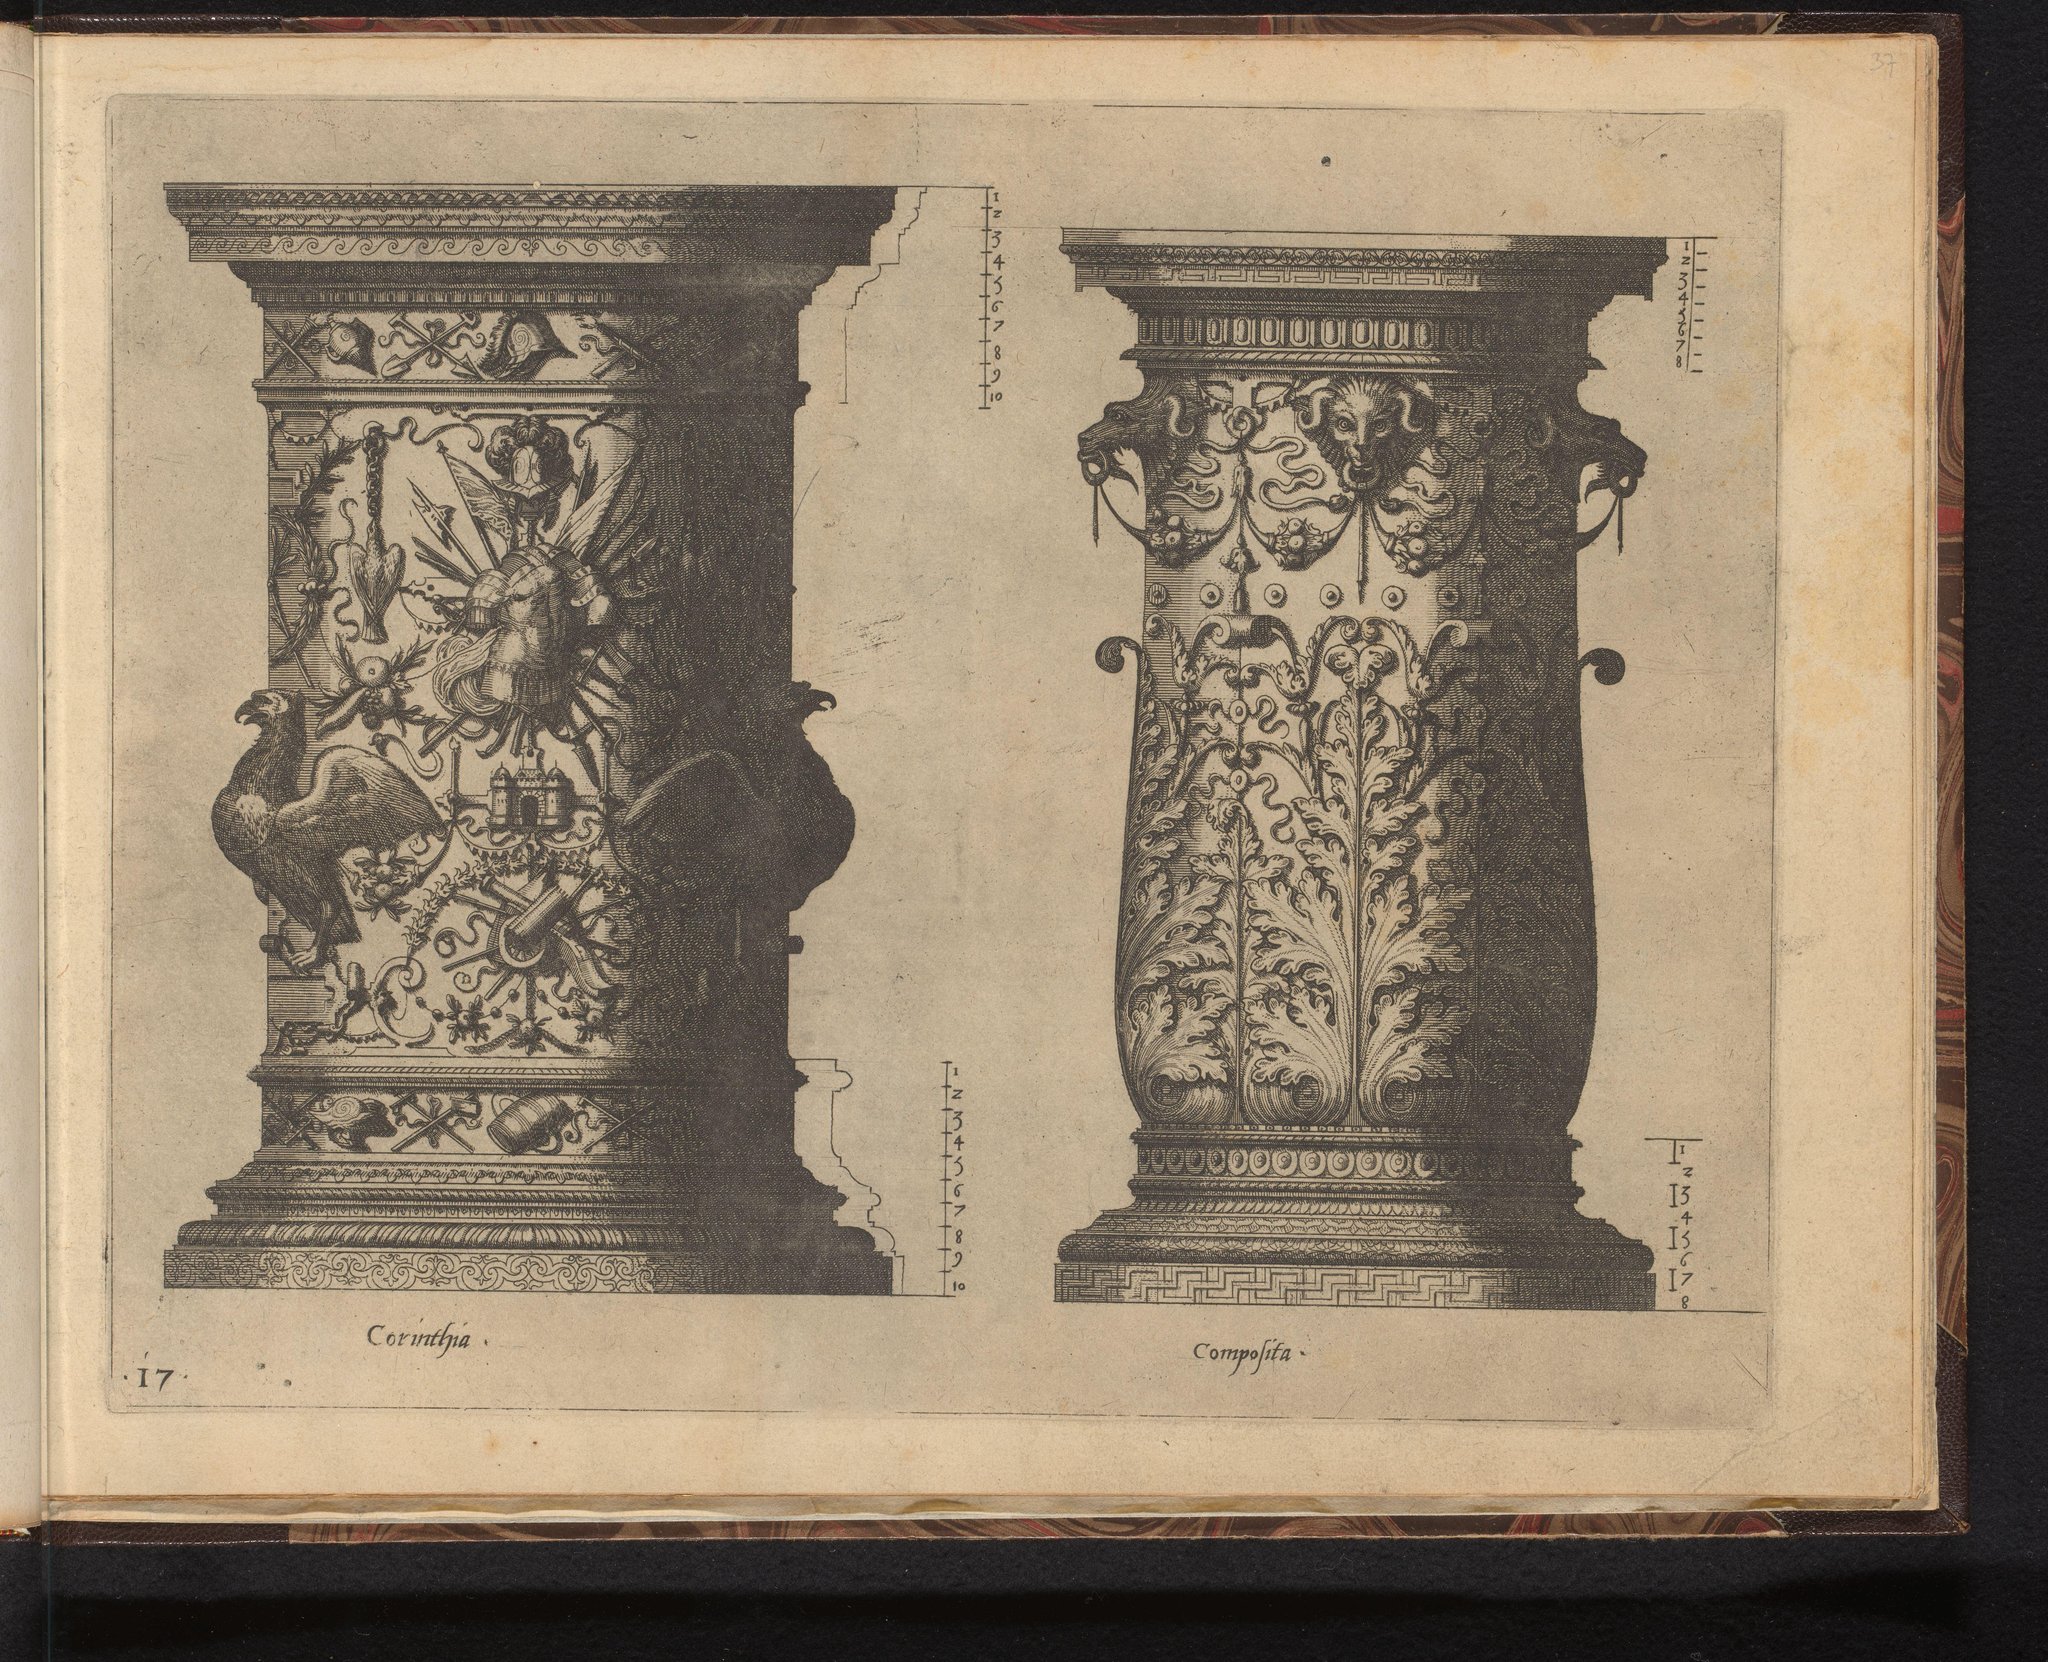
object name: print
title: Twee piëdestals, in de Korinthische en Composiete Orde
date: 1565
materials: paper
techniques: etching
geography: antwerp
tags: composite order ~ architecture, pedestal of a piece of sculpture (perhaps in the form of a herm), corinthian order ~ architecture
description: Twee piëdestals. Het linker piëdestal is gedecoreerd met trofeeën en twee adelaars, het rechter met acanthusbladeren en ramskopen. Op de prent is vier maal een schaalverdeling aangegeven. De prent maakt deel uit van een album.